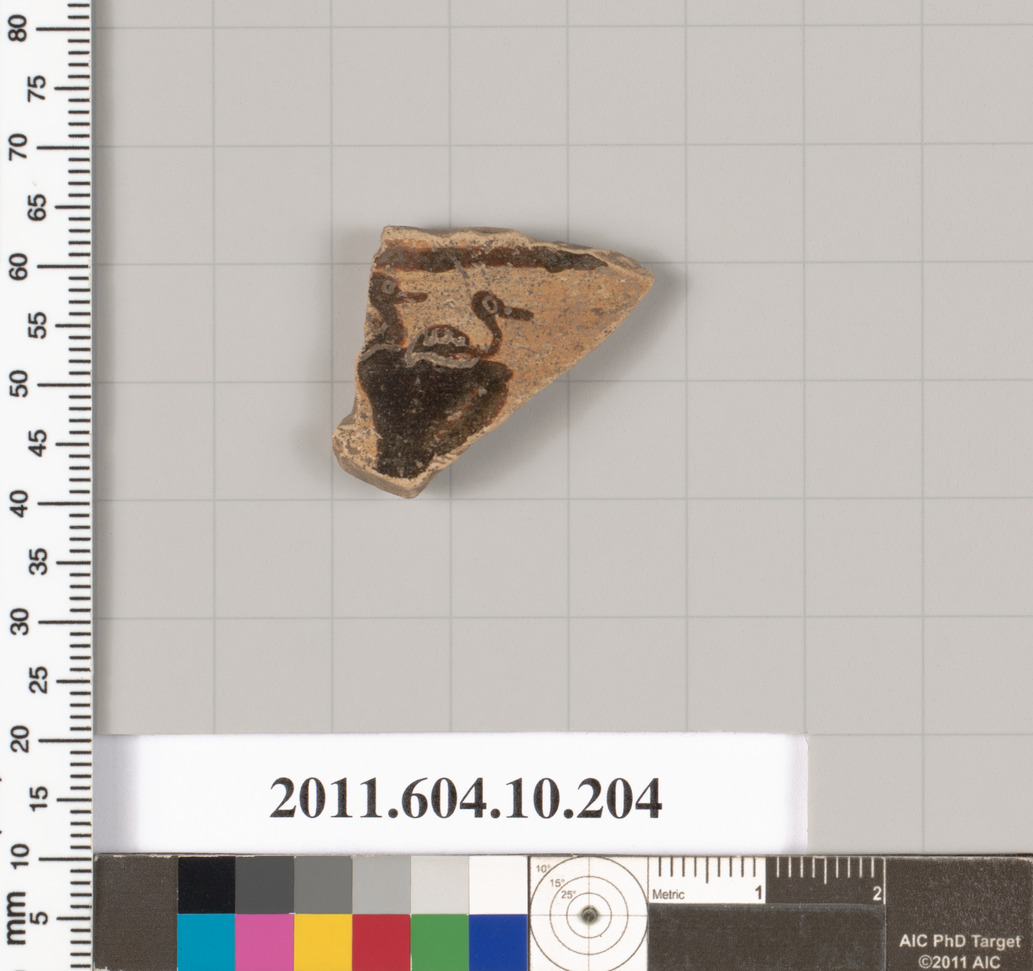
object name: underdetermined shape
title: Terracotta fragment of an undetermined shape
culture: etruscan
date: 534-468 BCE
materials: terracotta